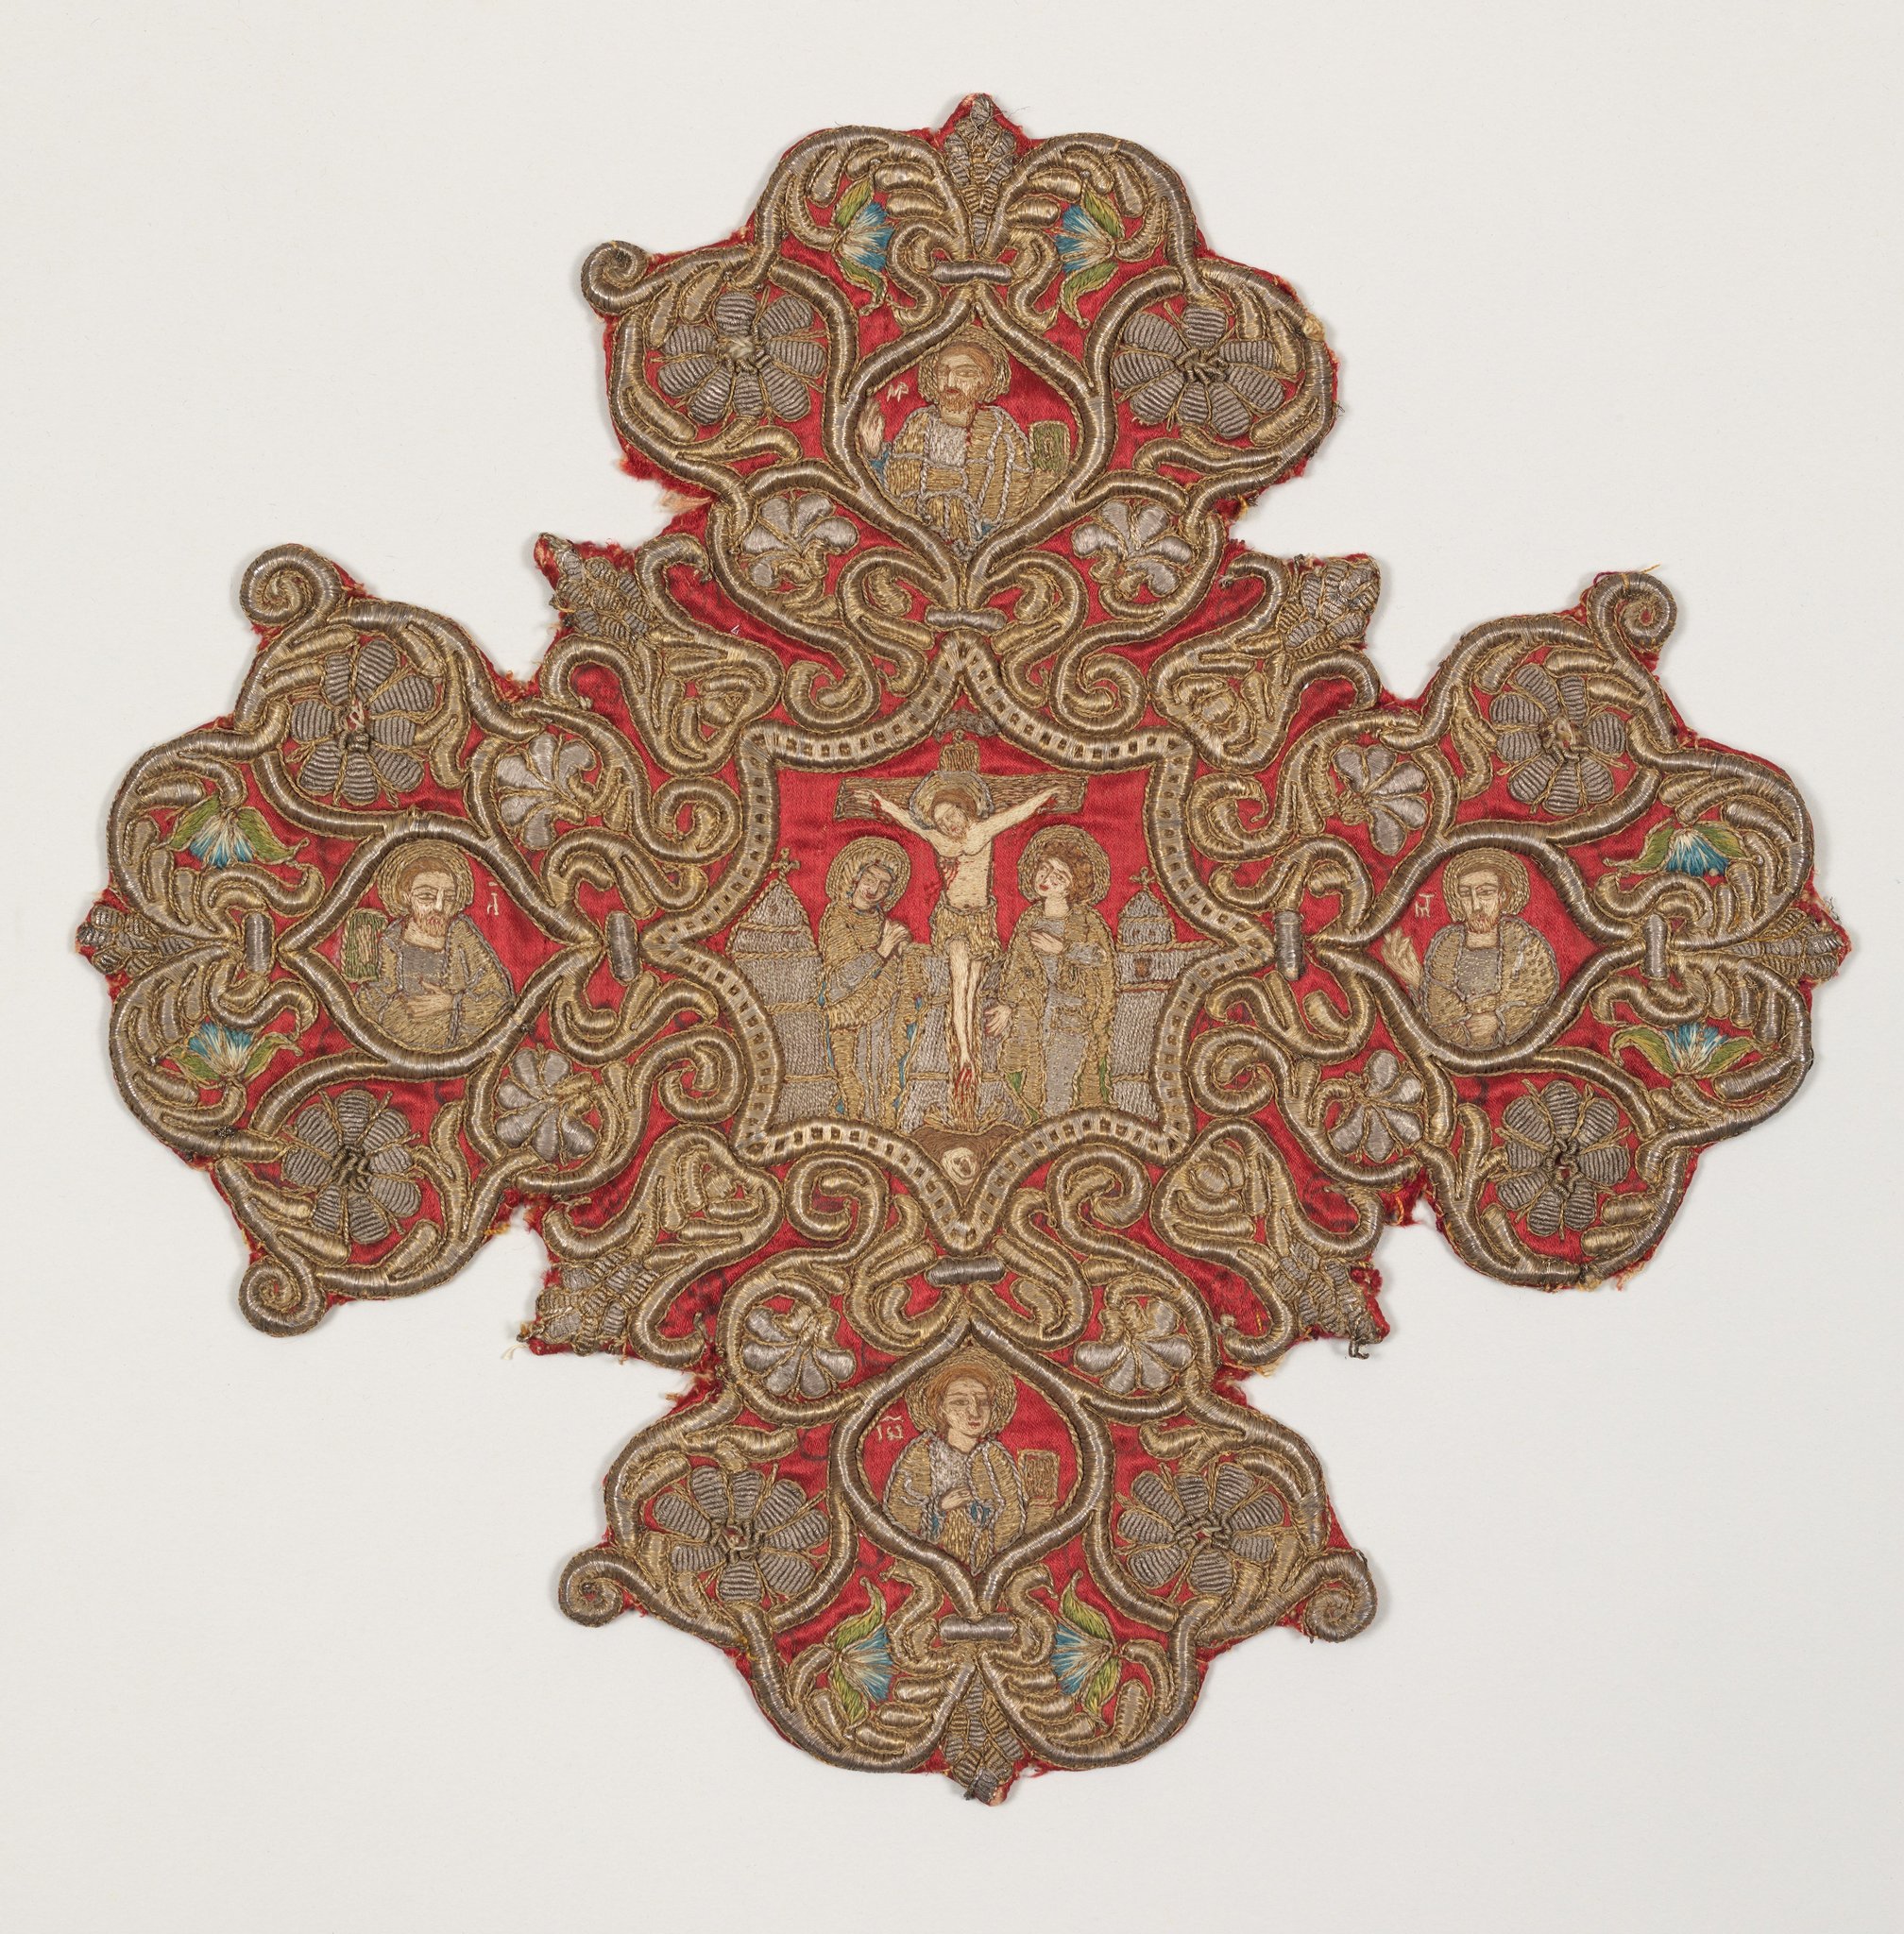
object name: embroidered cross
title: Embroidered cross from an Omophorion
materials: linen, metal thread, silk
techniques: backing, embroidery, weave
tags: men,flowers,christ,cross,crucifixion